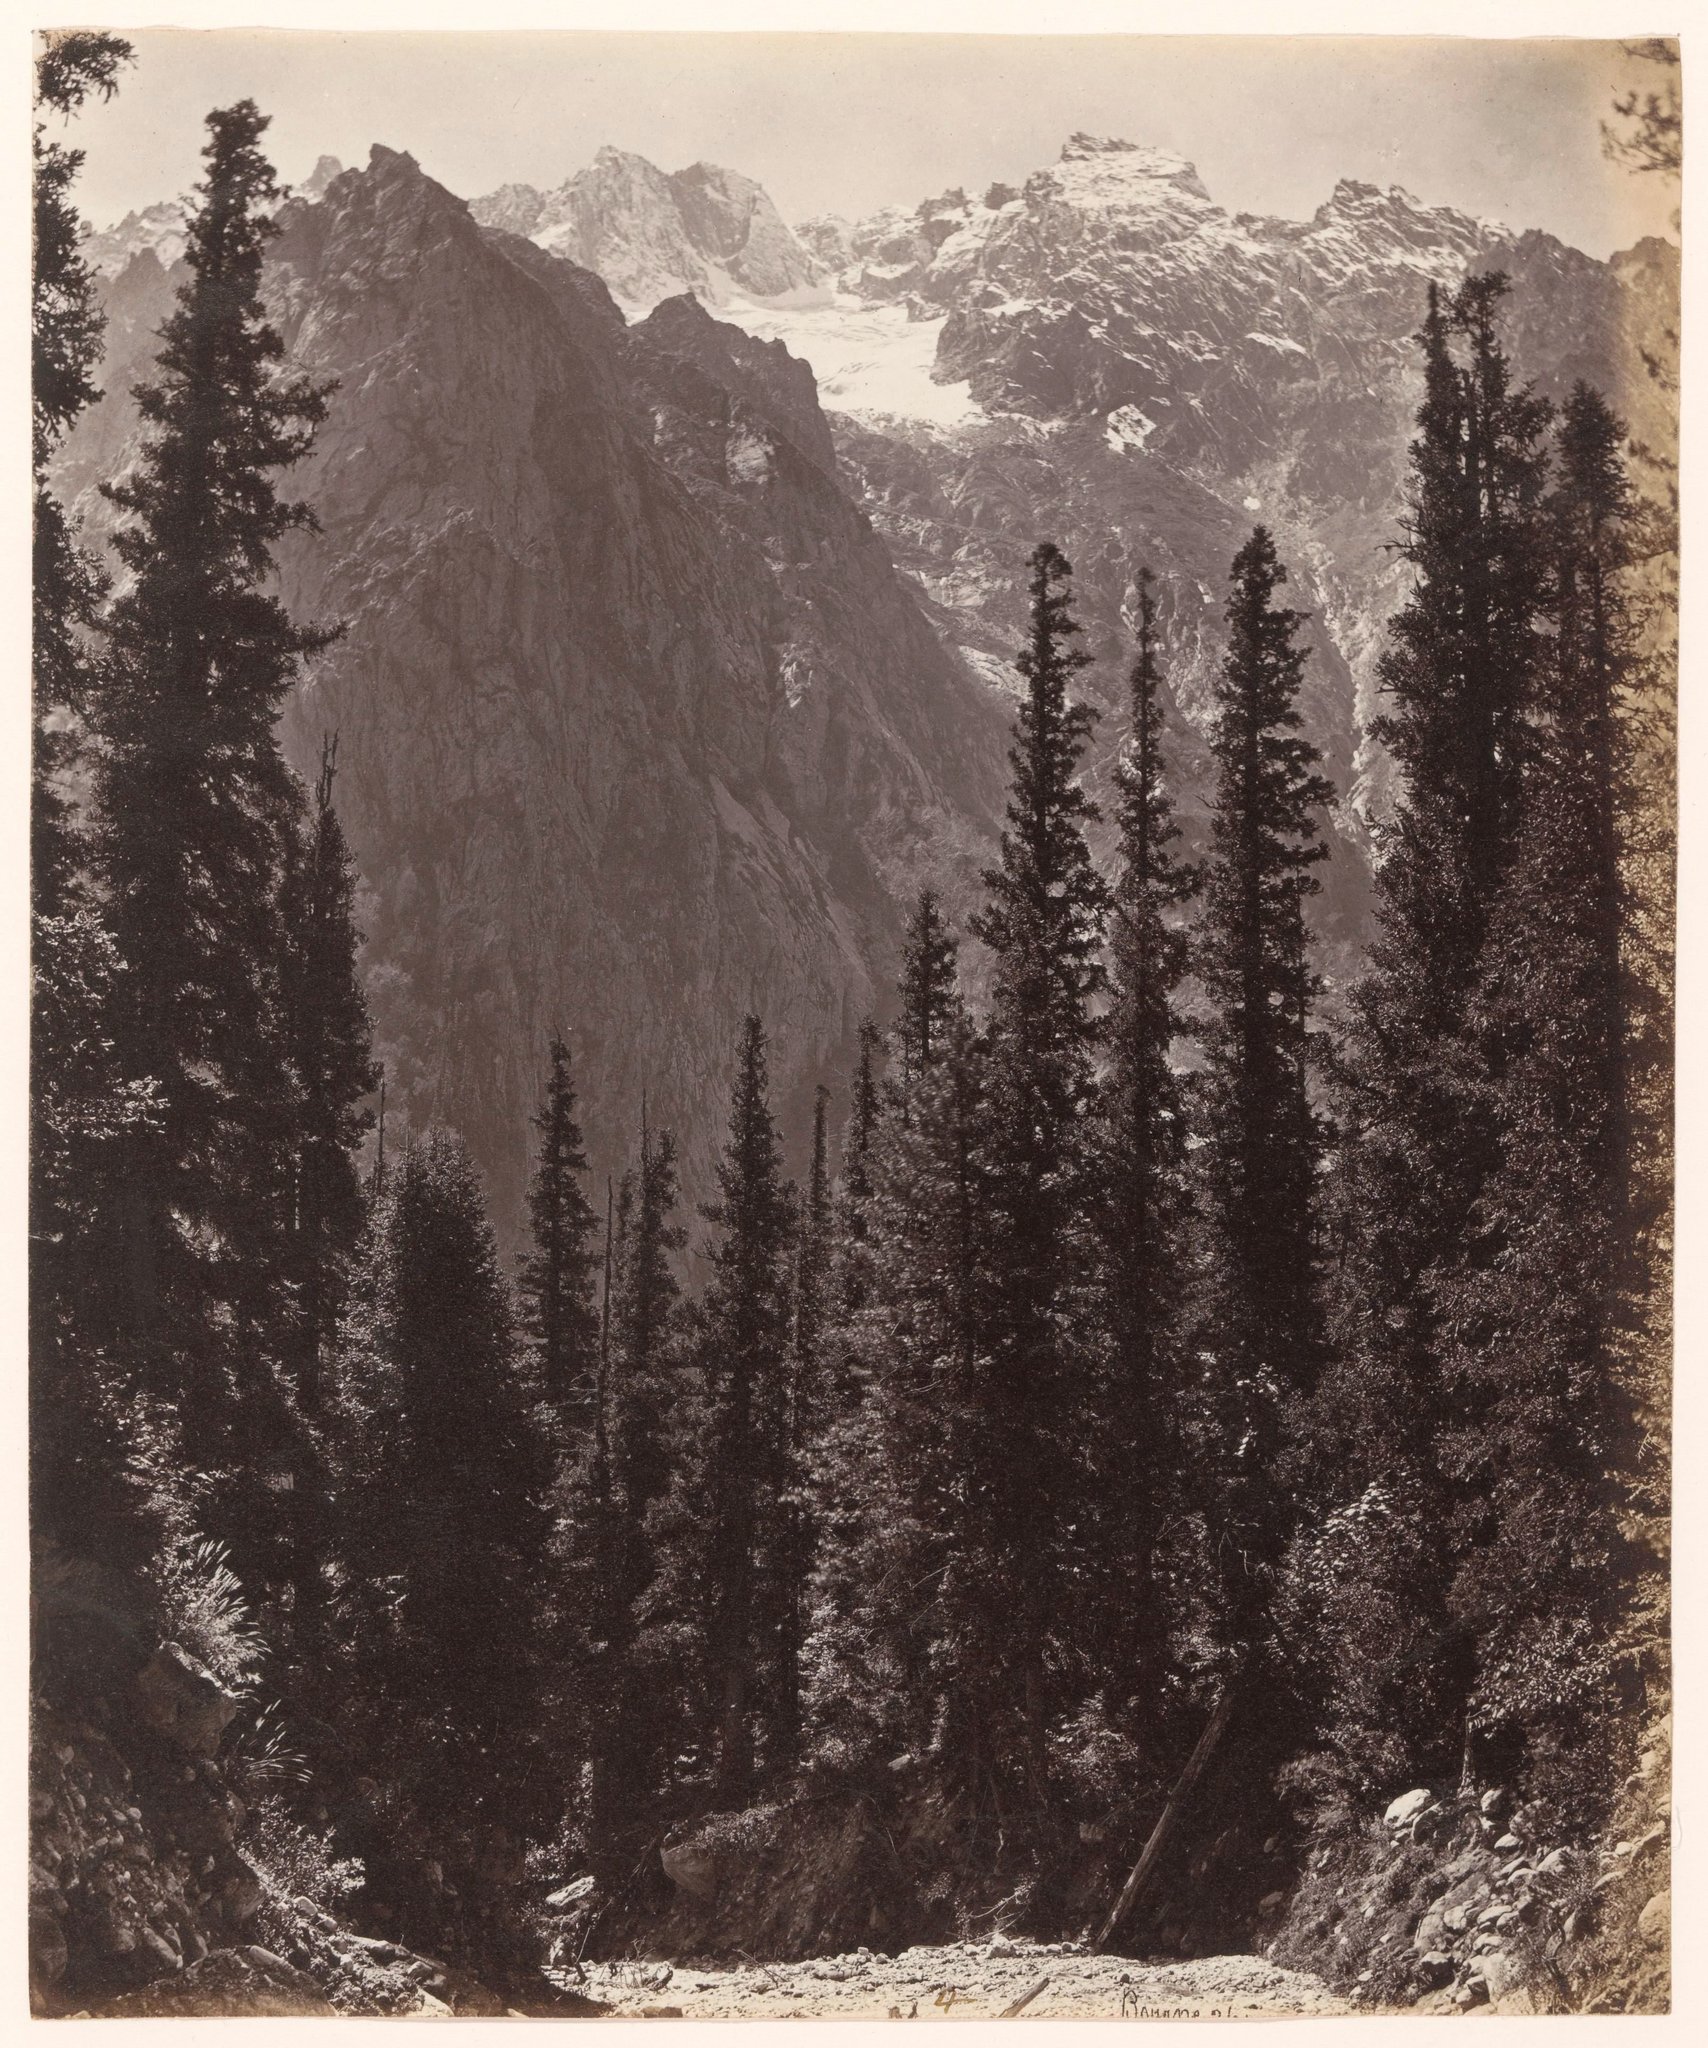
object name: photograph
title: Berglandschap met sparren in Wanga Valley, India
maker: samuel bourne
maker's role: fotograaf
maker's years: 1834-1912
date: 1863-1864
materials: paper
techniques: albumen print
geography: british india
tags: trees: pine, mountains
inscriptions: number: ‘4’, number: ‘261’